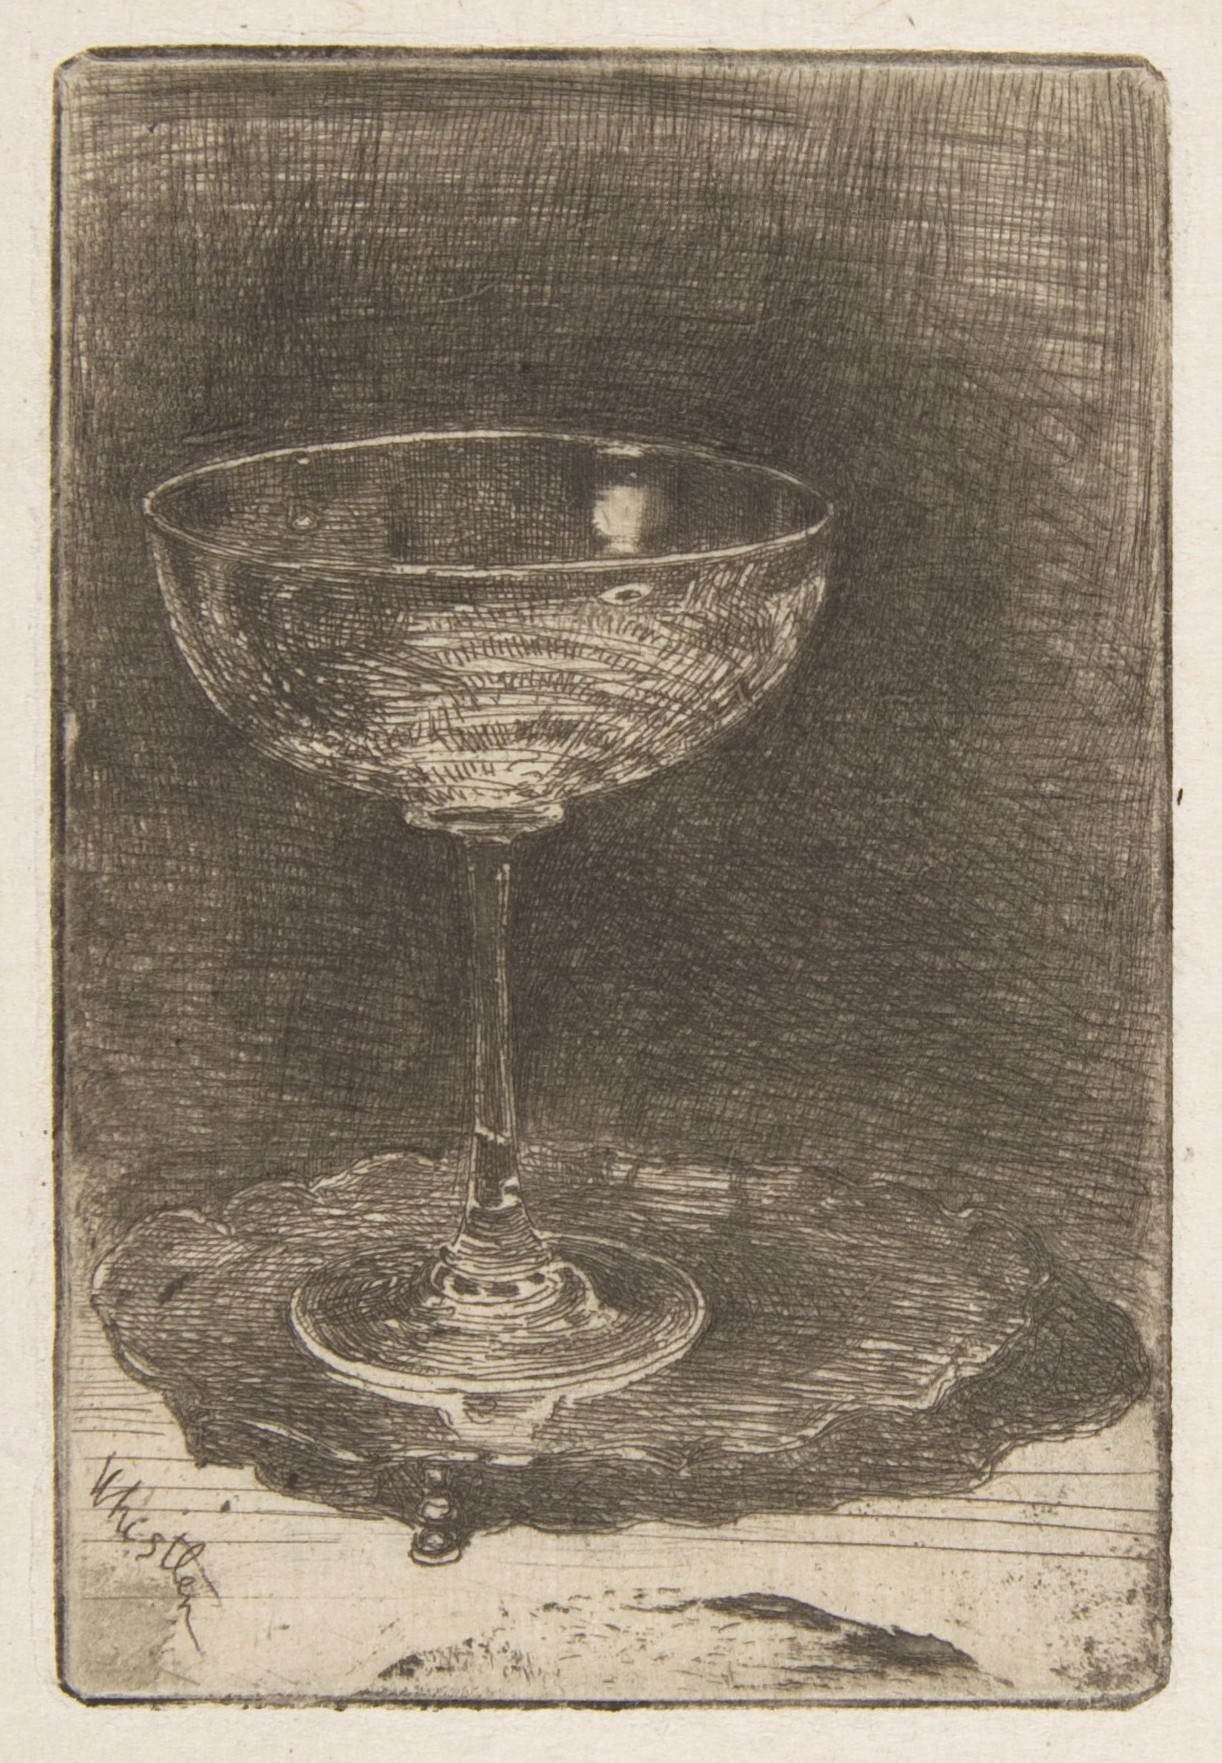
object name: print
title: The Wine Glass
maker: james mcneill whistler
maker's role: artist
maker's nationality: american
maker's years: 1834-1903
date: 1858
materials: ink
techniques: etching, printing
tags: drinking glasses